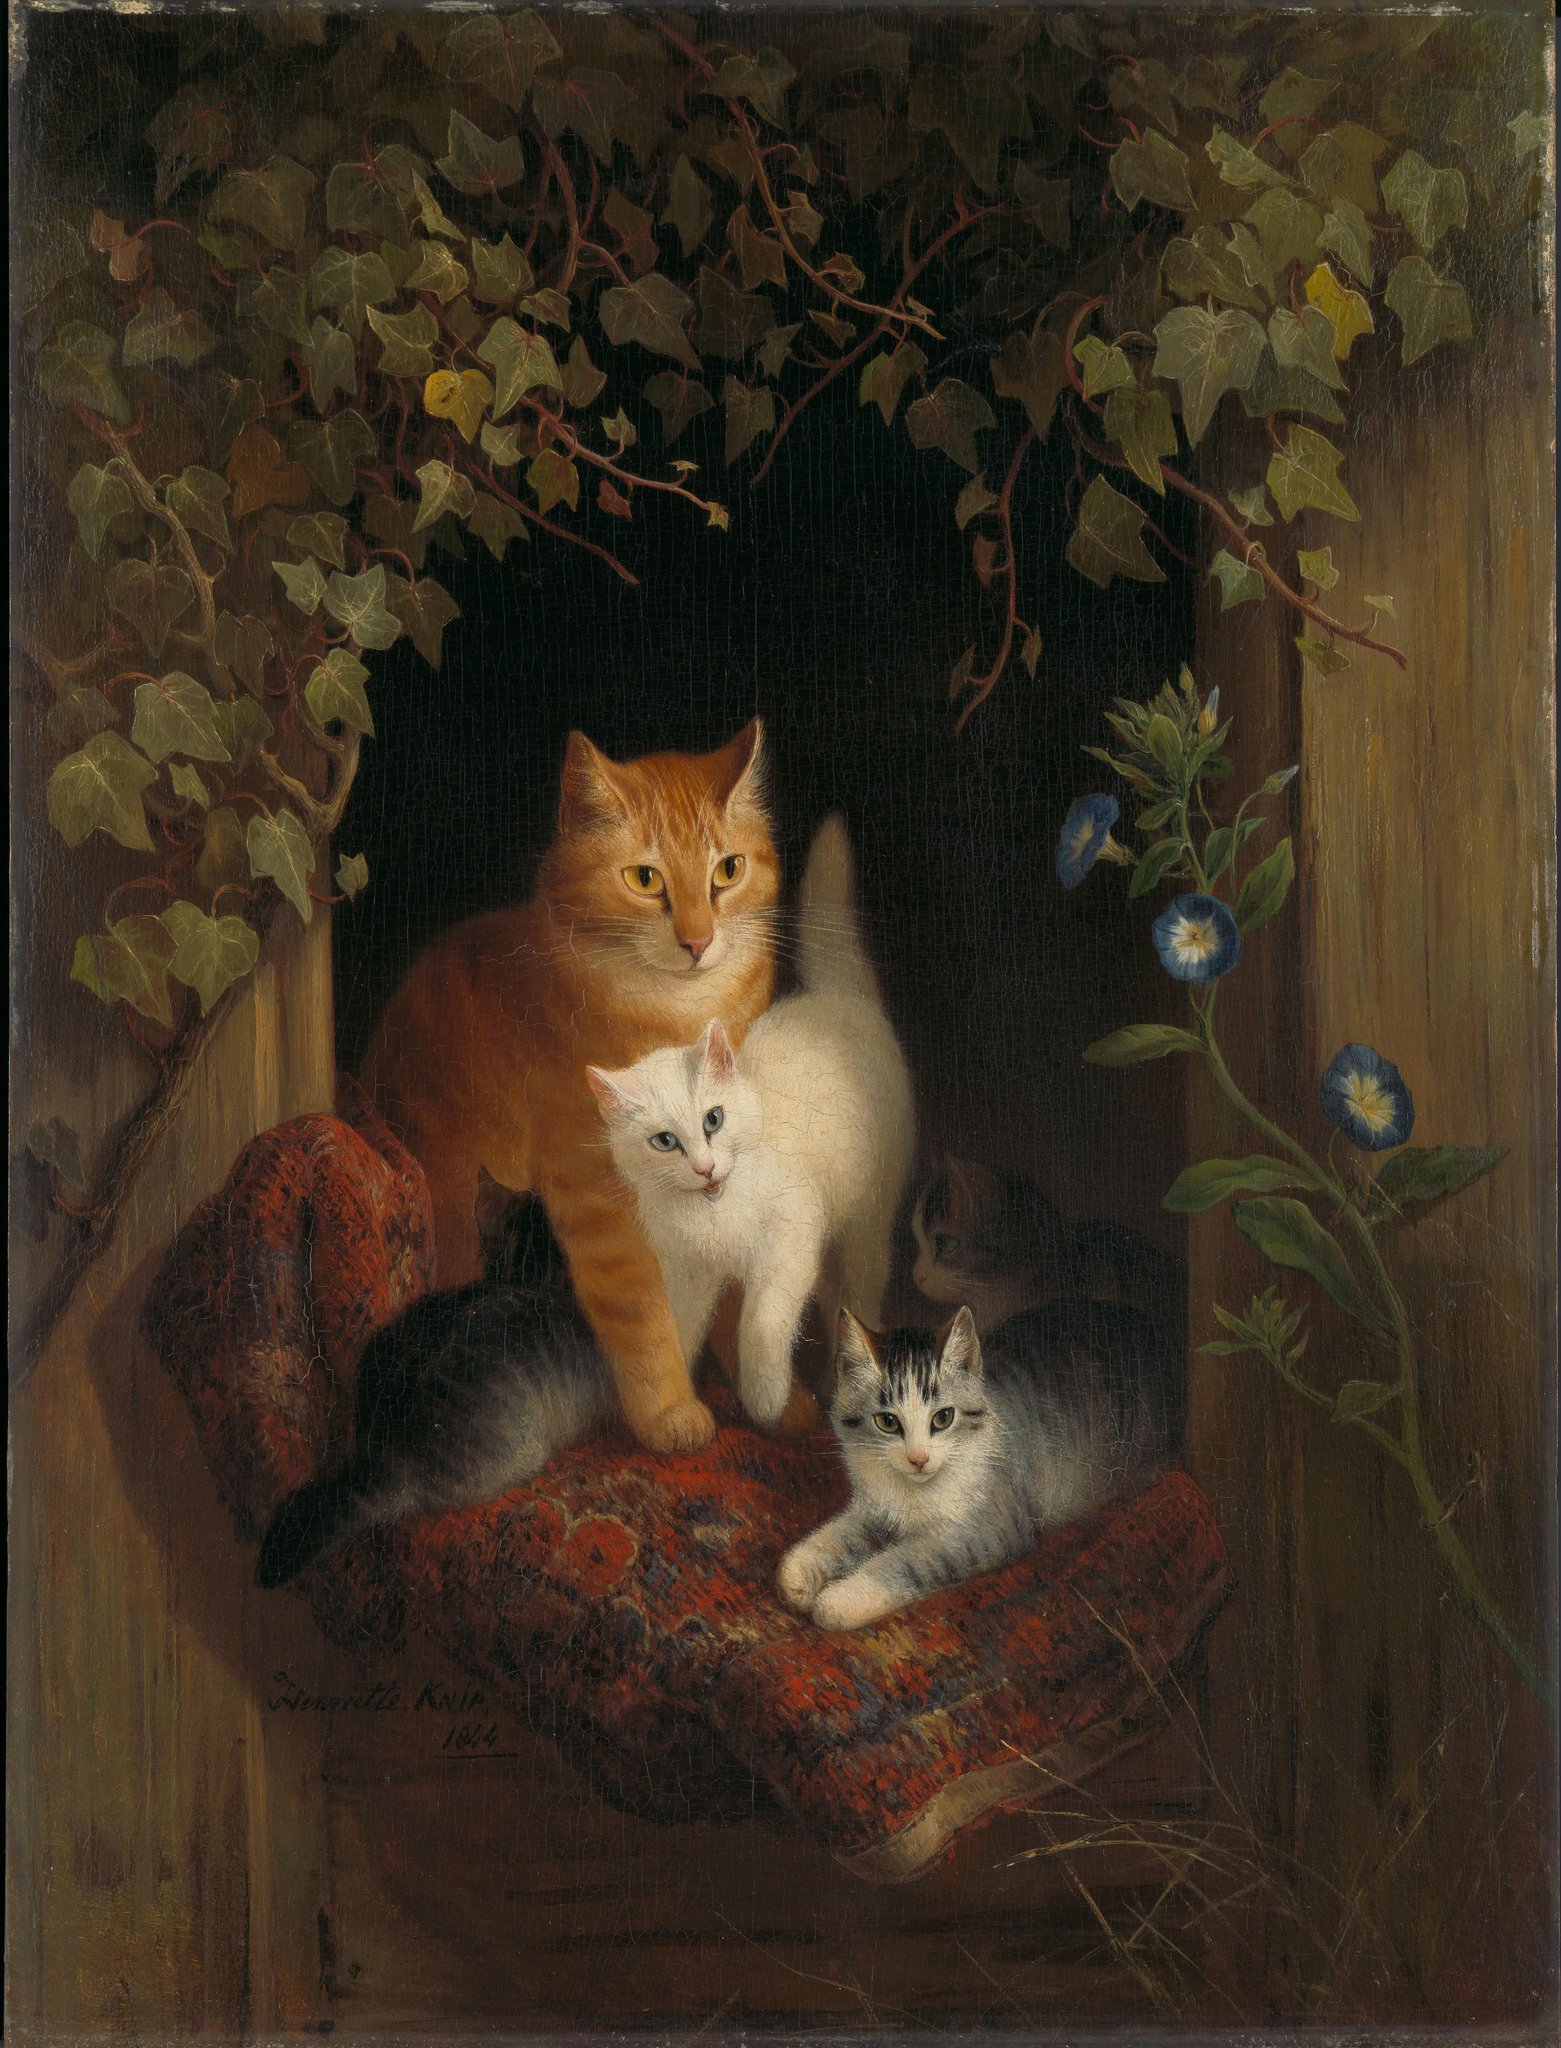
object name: painting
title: Cat with Kittens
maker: henriëtte ronner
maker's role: draughtsman, painter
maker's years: 1821-1909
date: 1844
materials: oil, panel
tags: cat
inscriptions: signature and date: ‘Henriette Knip 1844’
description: Kat met jongen. In het raam van een houten schuur zit een kat met vier jongen op een oude deken. Rond het venster klimop en winde.